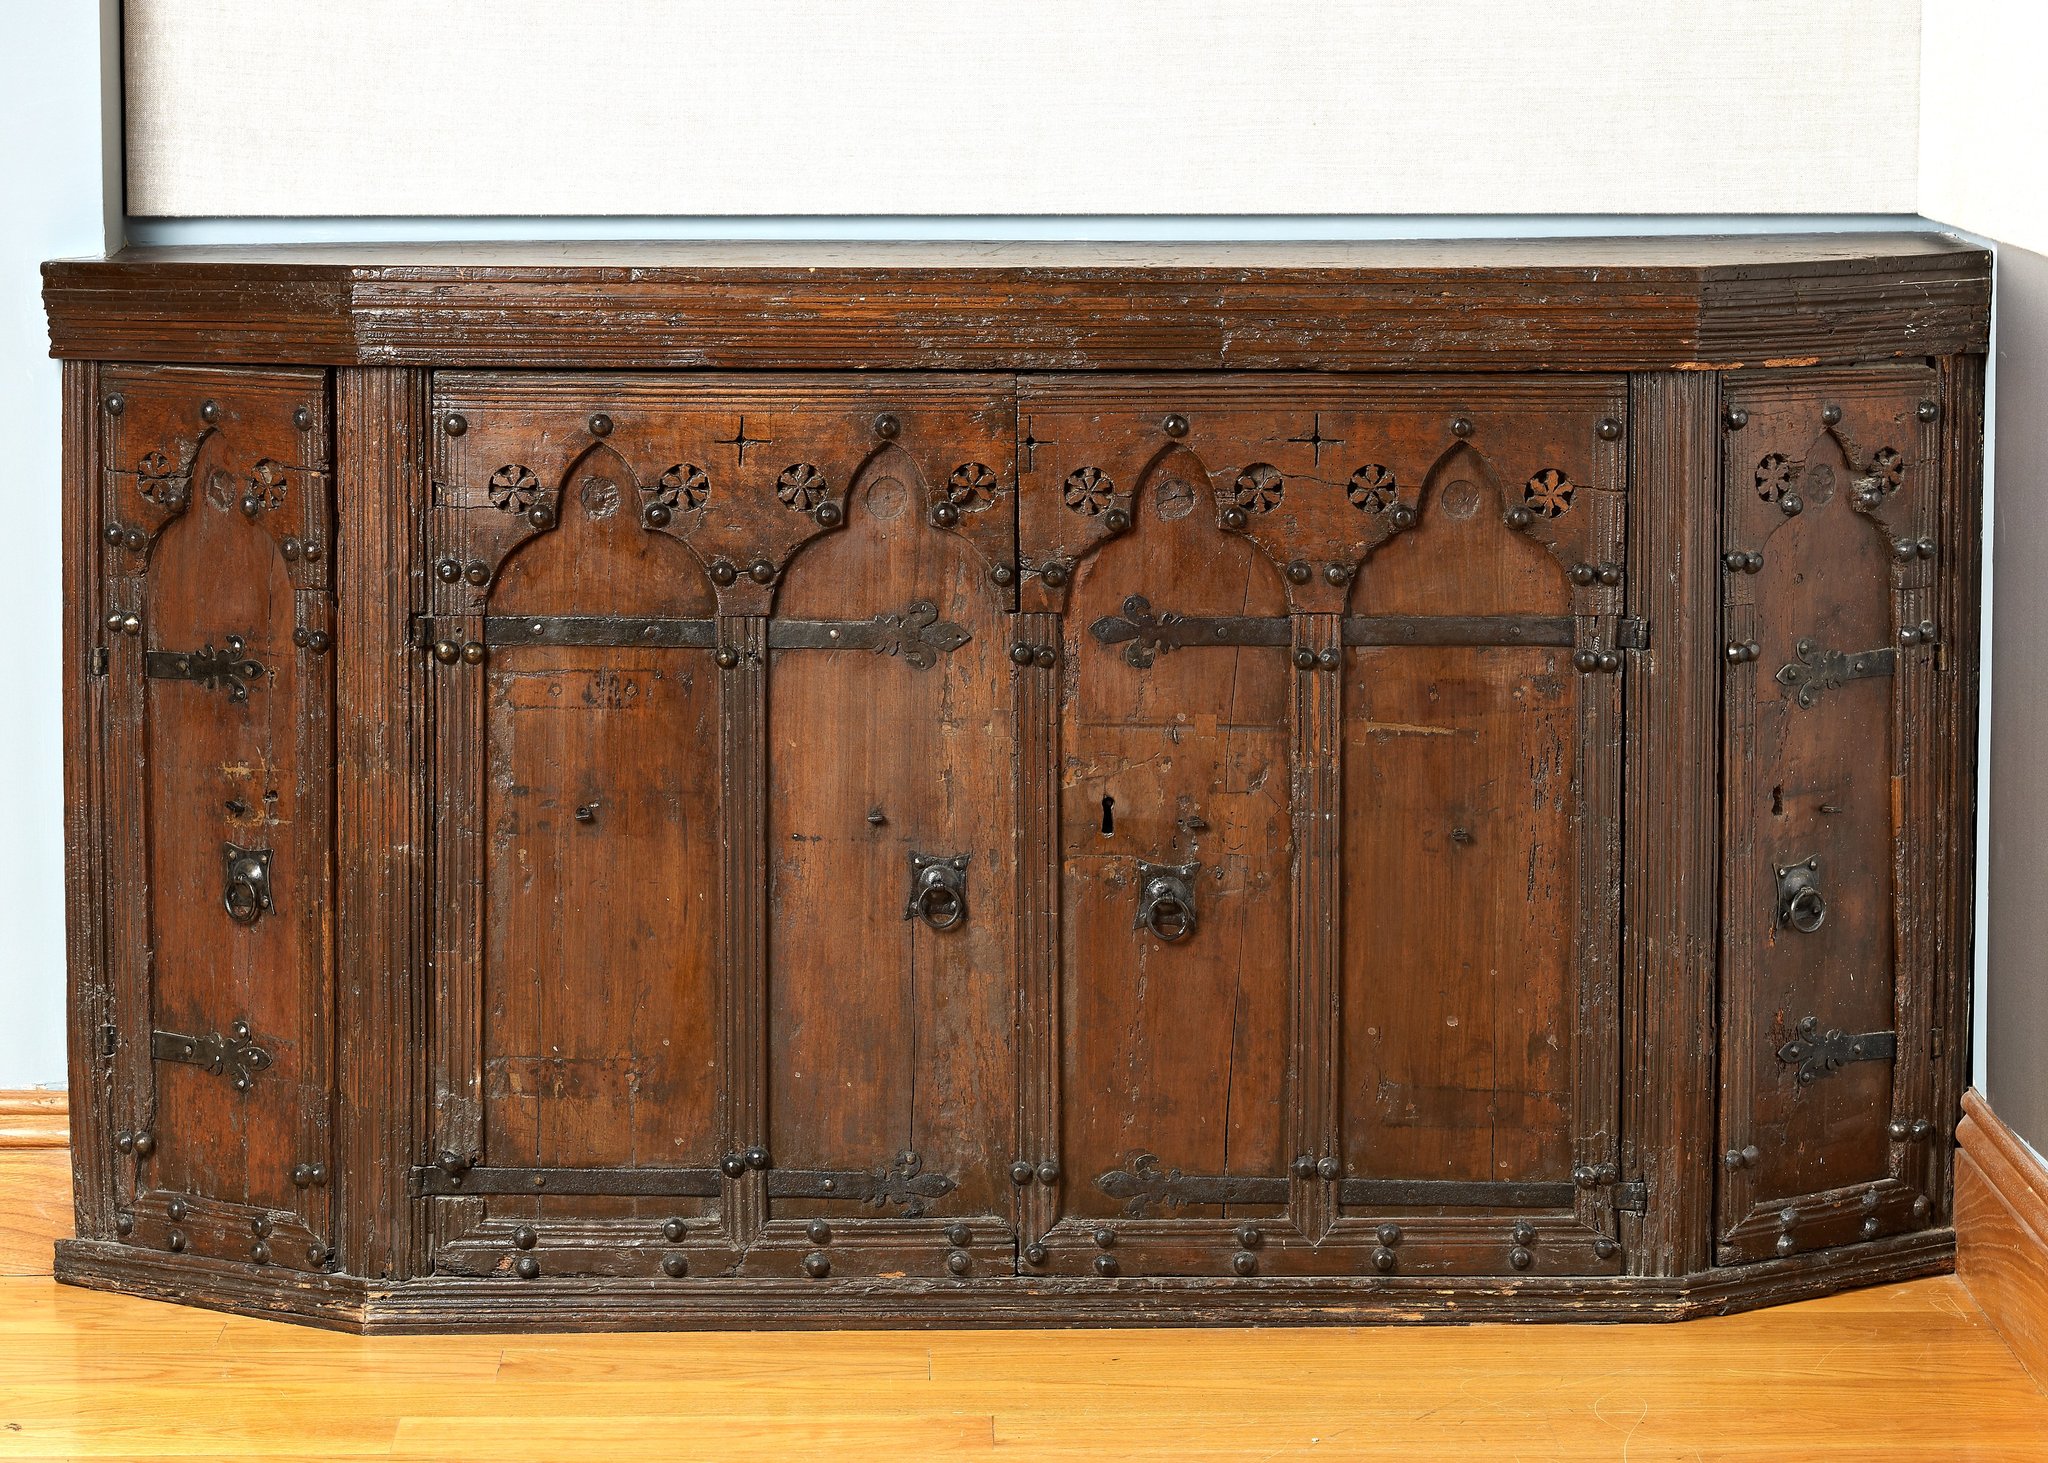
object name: cabinet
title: Cabinet (installed with 1975.1.2017)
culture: italian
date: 1400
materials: iron, wood